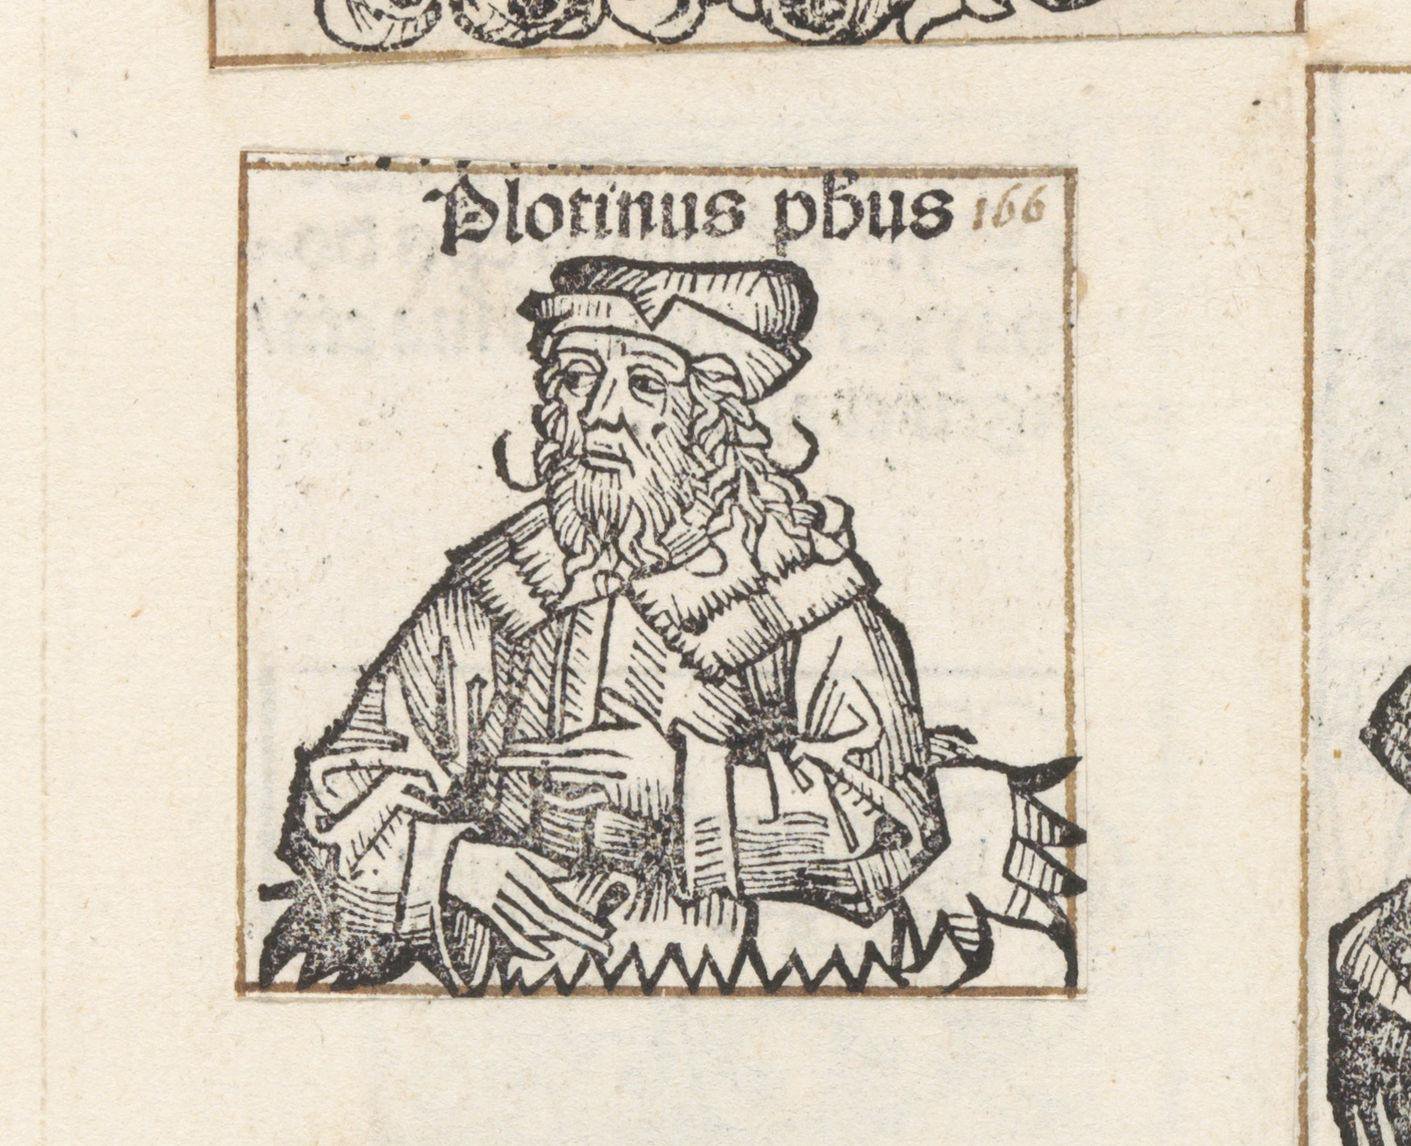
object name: book illustration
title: Plotinus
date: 1493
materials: paper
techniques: letterpress printing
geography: nuremberg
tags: male persons from classical history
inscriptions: inscription: ‘166’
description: De houtsnede wordt gebruikt als boekillustratie in de Liber Chronicarum (of Neurenbergkroniek) van Hartmann Schedel, verschenen in het Latijn en Duits in 1493. Zie de Latijnse uitgave, folio 74v.